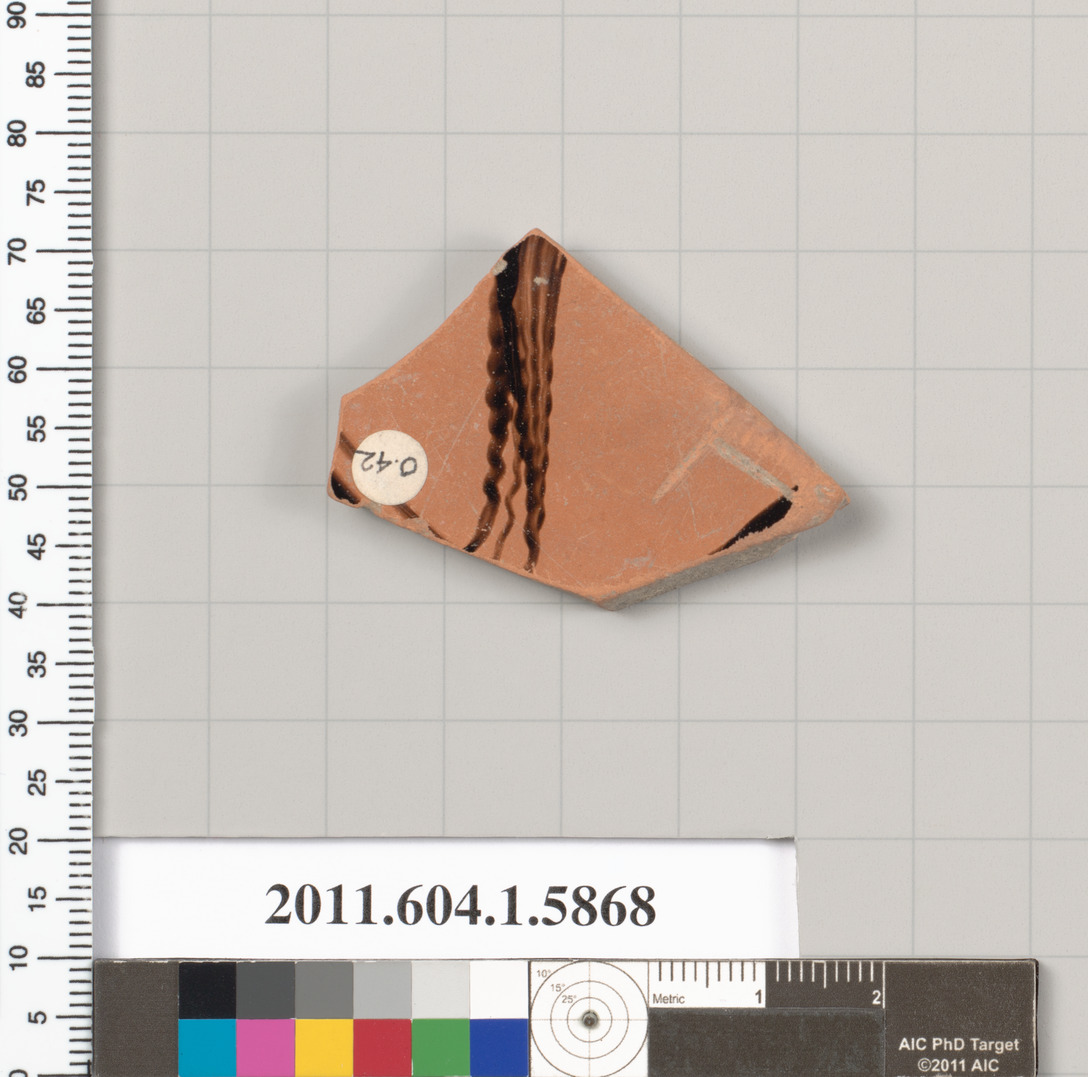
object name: kylix fragment, eye cup, bilingual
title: Terracotta fragment of a kylix (drinking cup)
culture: greek, attic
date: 433-567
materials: terracotta